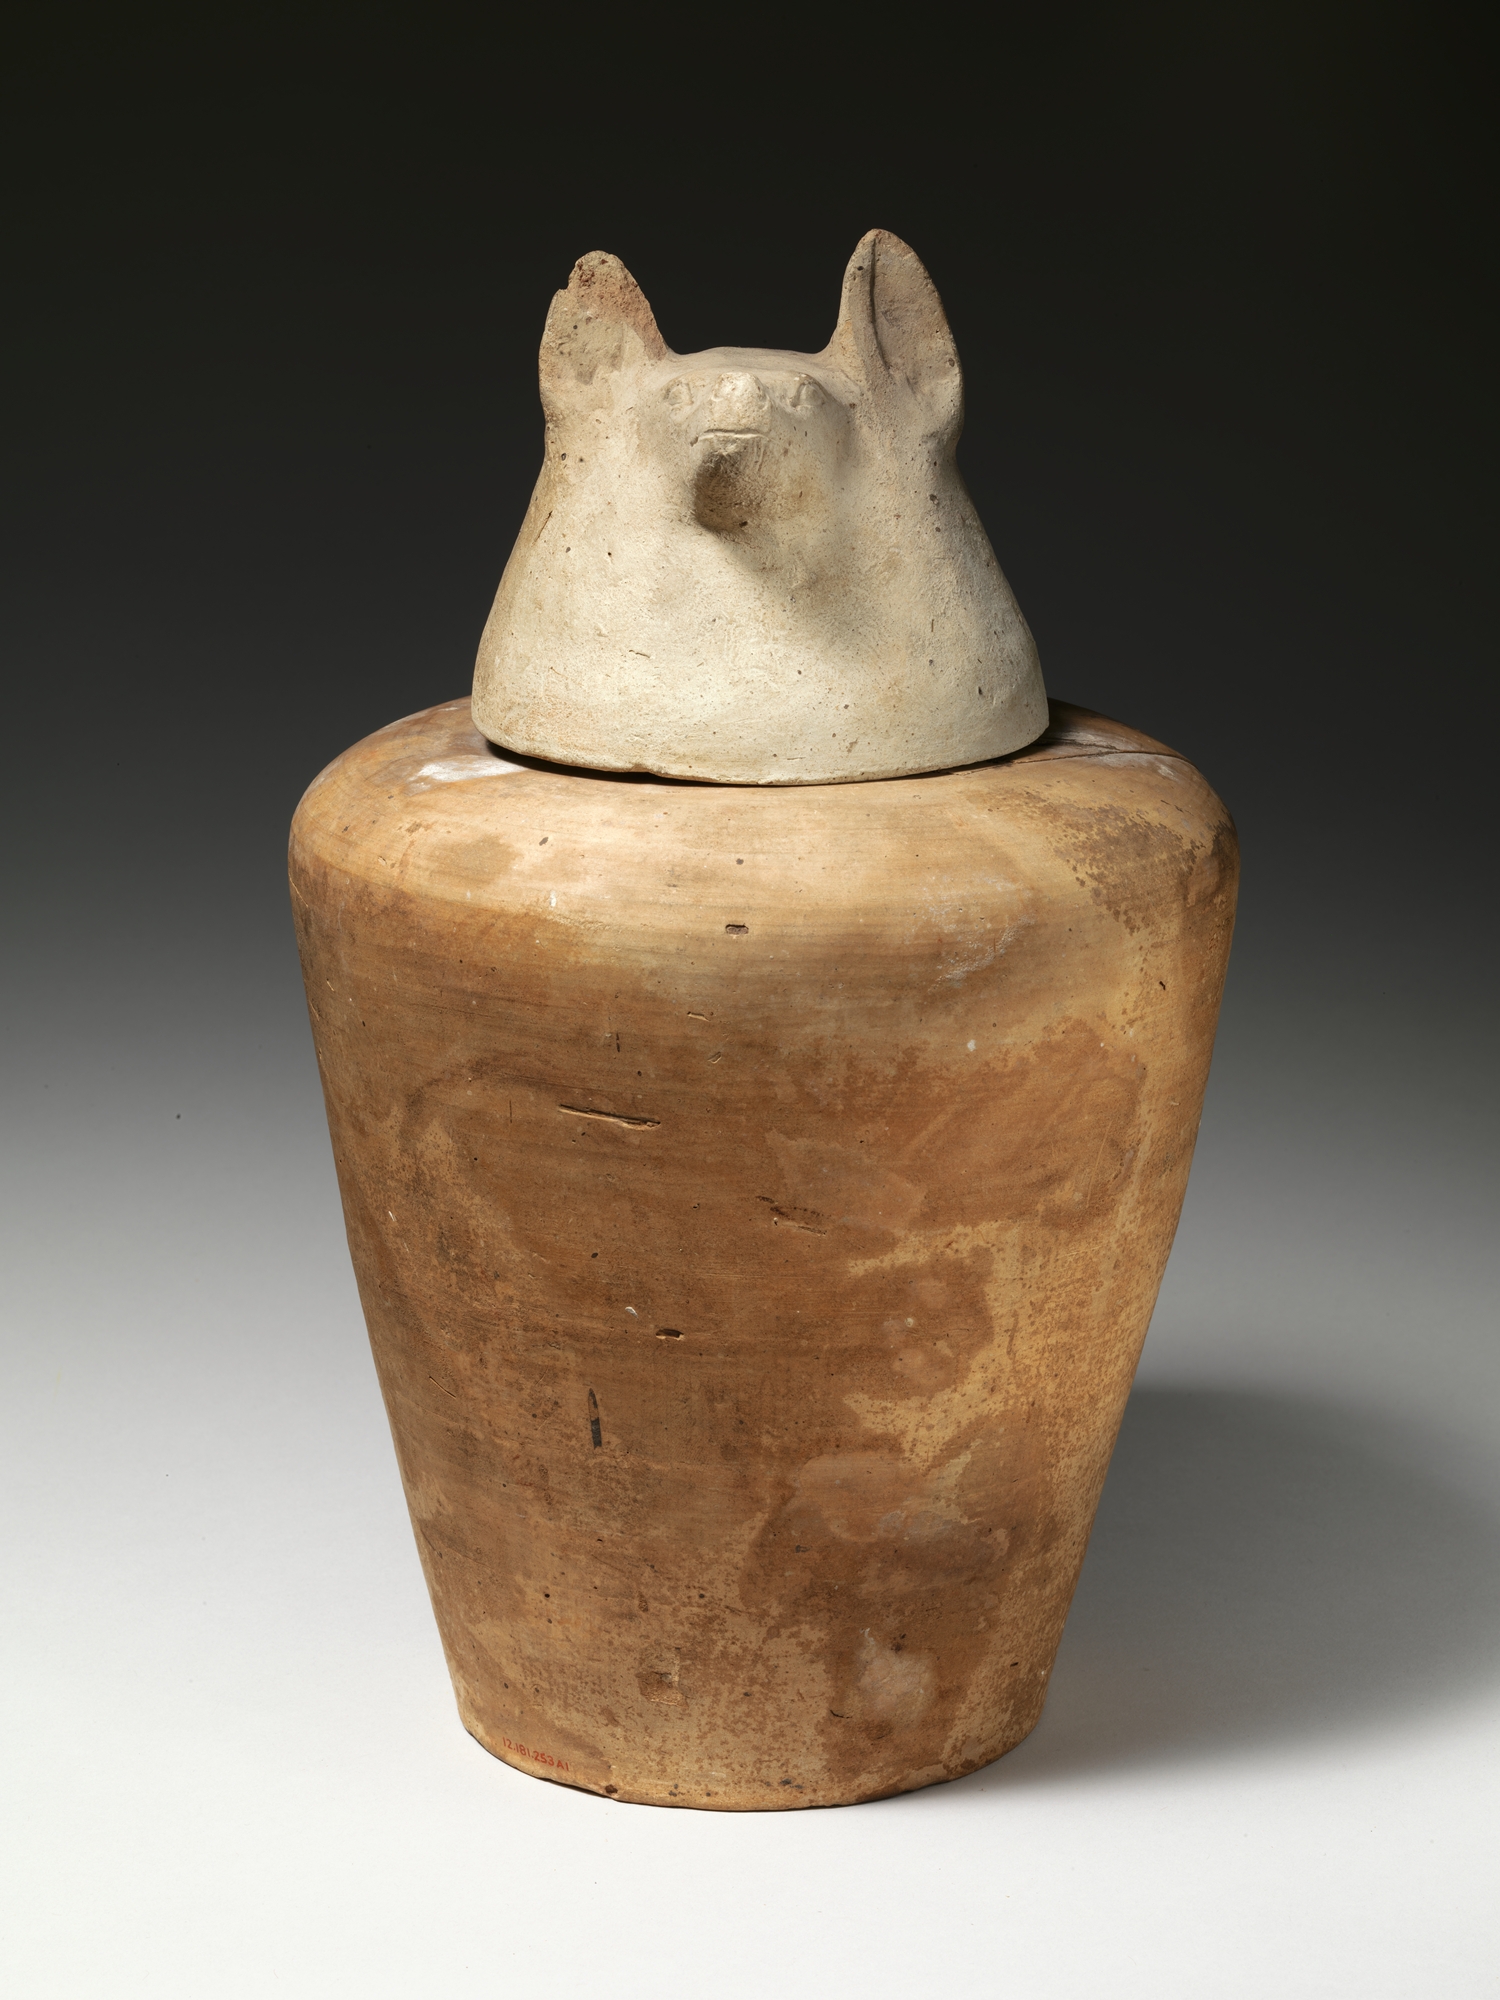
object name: canopic jar, jackal lid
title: Canopic jar of Tetinakht: Duamutef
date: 1550-1525 BCE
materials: pottery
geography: egypt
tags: jackals